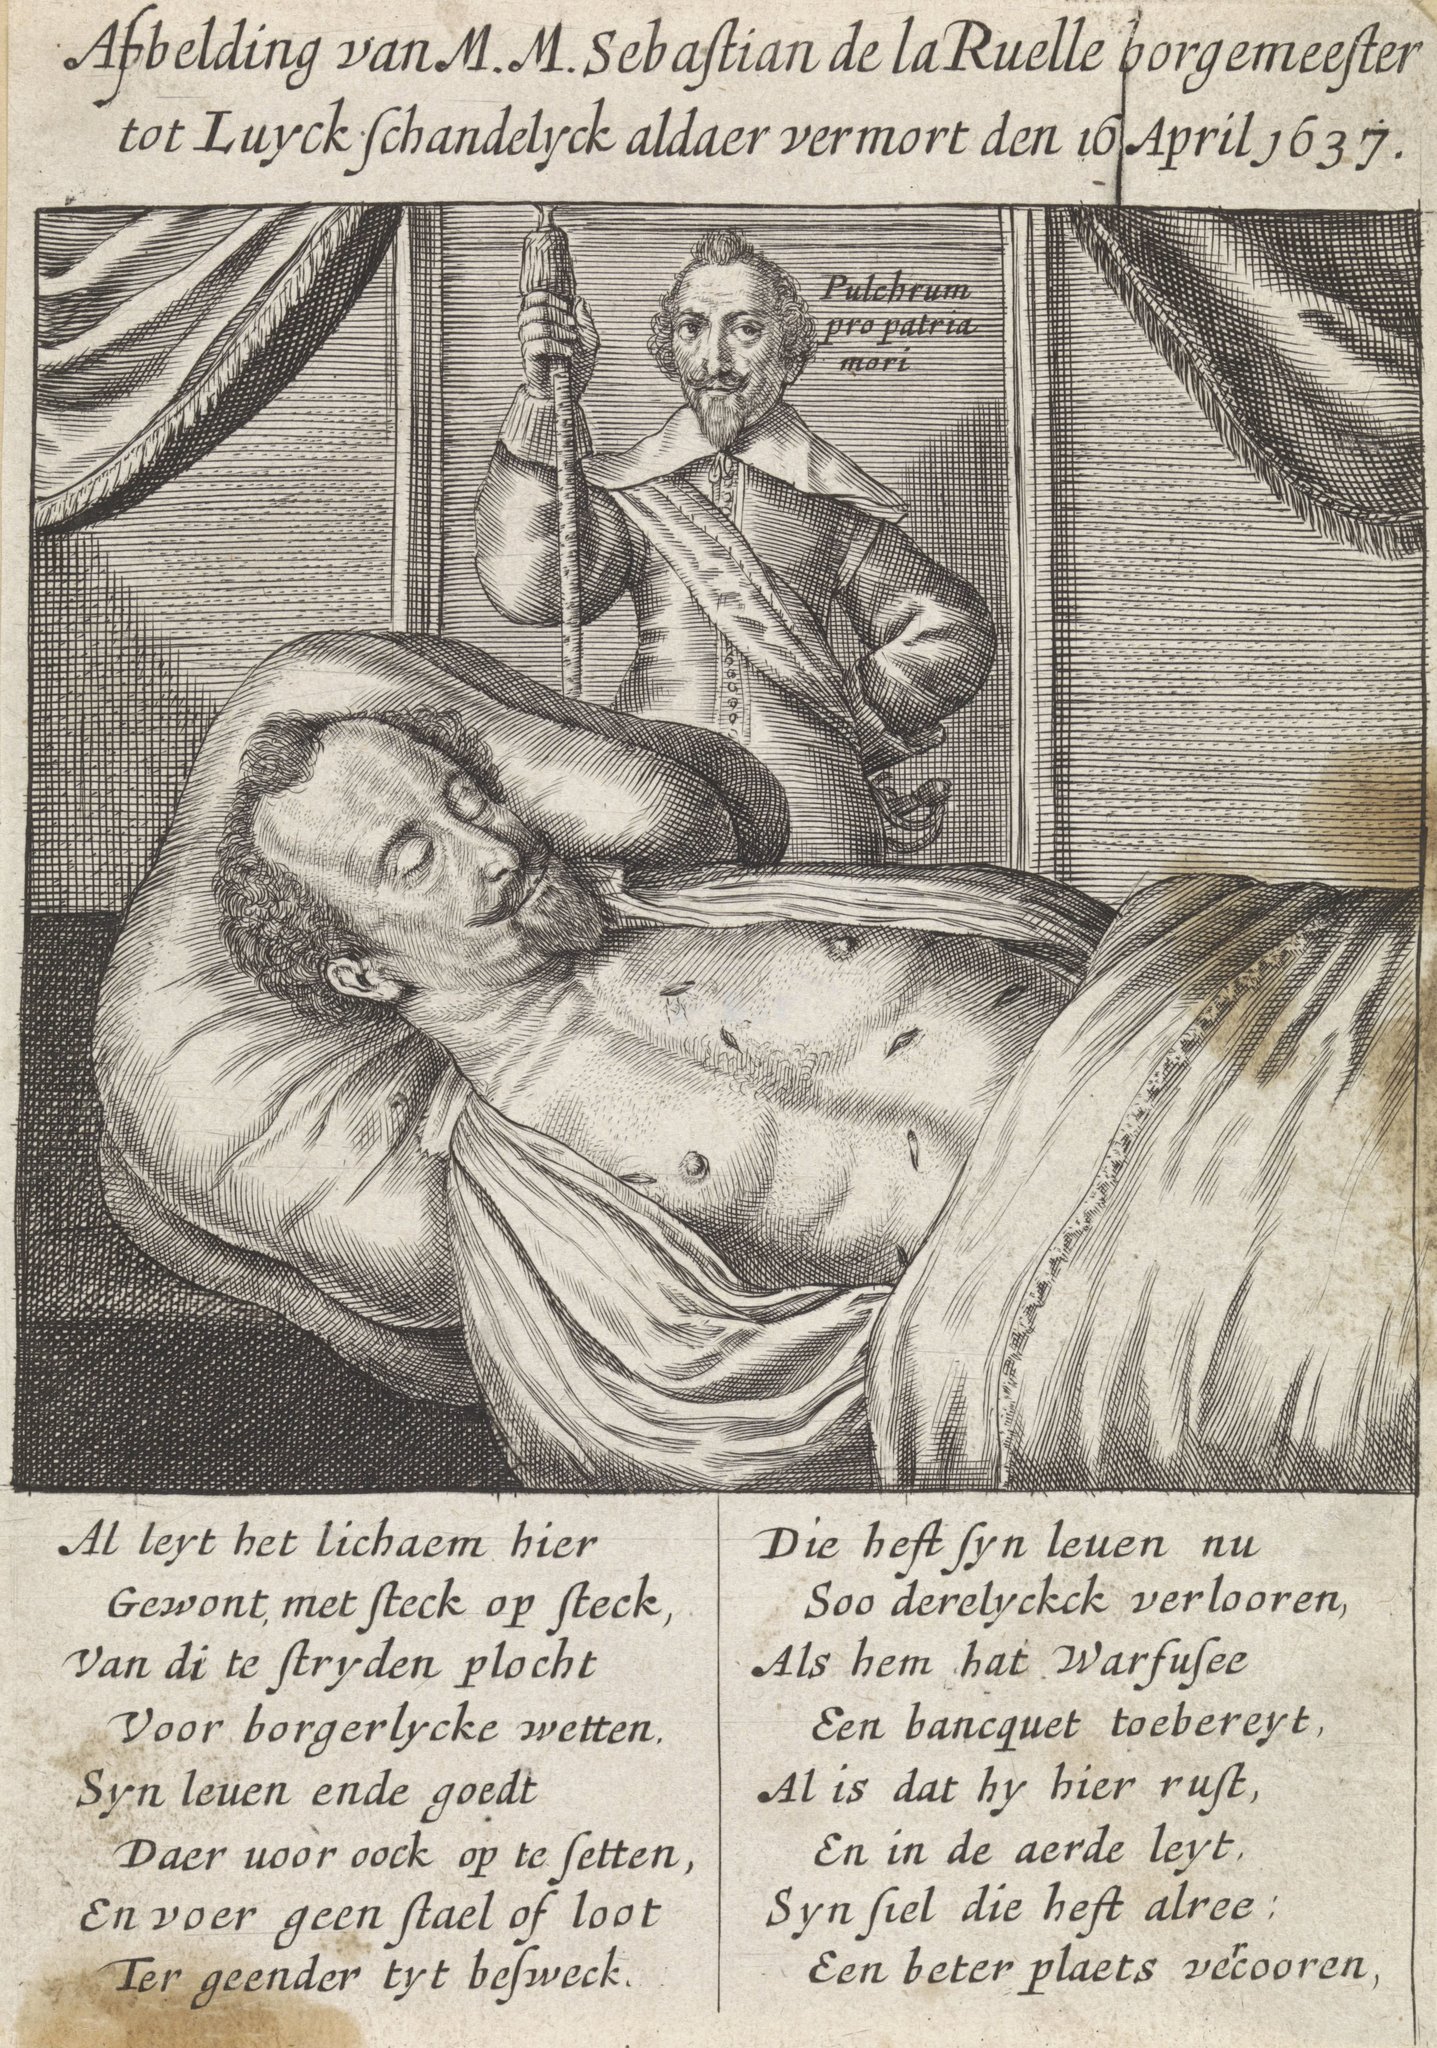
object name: print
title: Dood van Sébastien de La Ruelle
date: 1637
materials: paper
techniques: engraving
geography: liège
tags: politician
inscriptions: collector's mark: Lugt 2228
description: De vermoorde Sébastien de La Ruelle, burgemeester van Luik, het hoofd op een kussen en de verwonde borst ontbloot. Op de achtergrond een portret van Sébastien de La Ruelle ten halven lijve. Onderaan in de marge twee achtregelige verzen in het Nederlands.